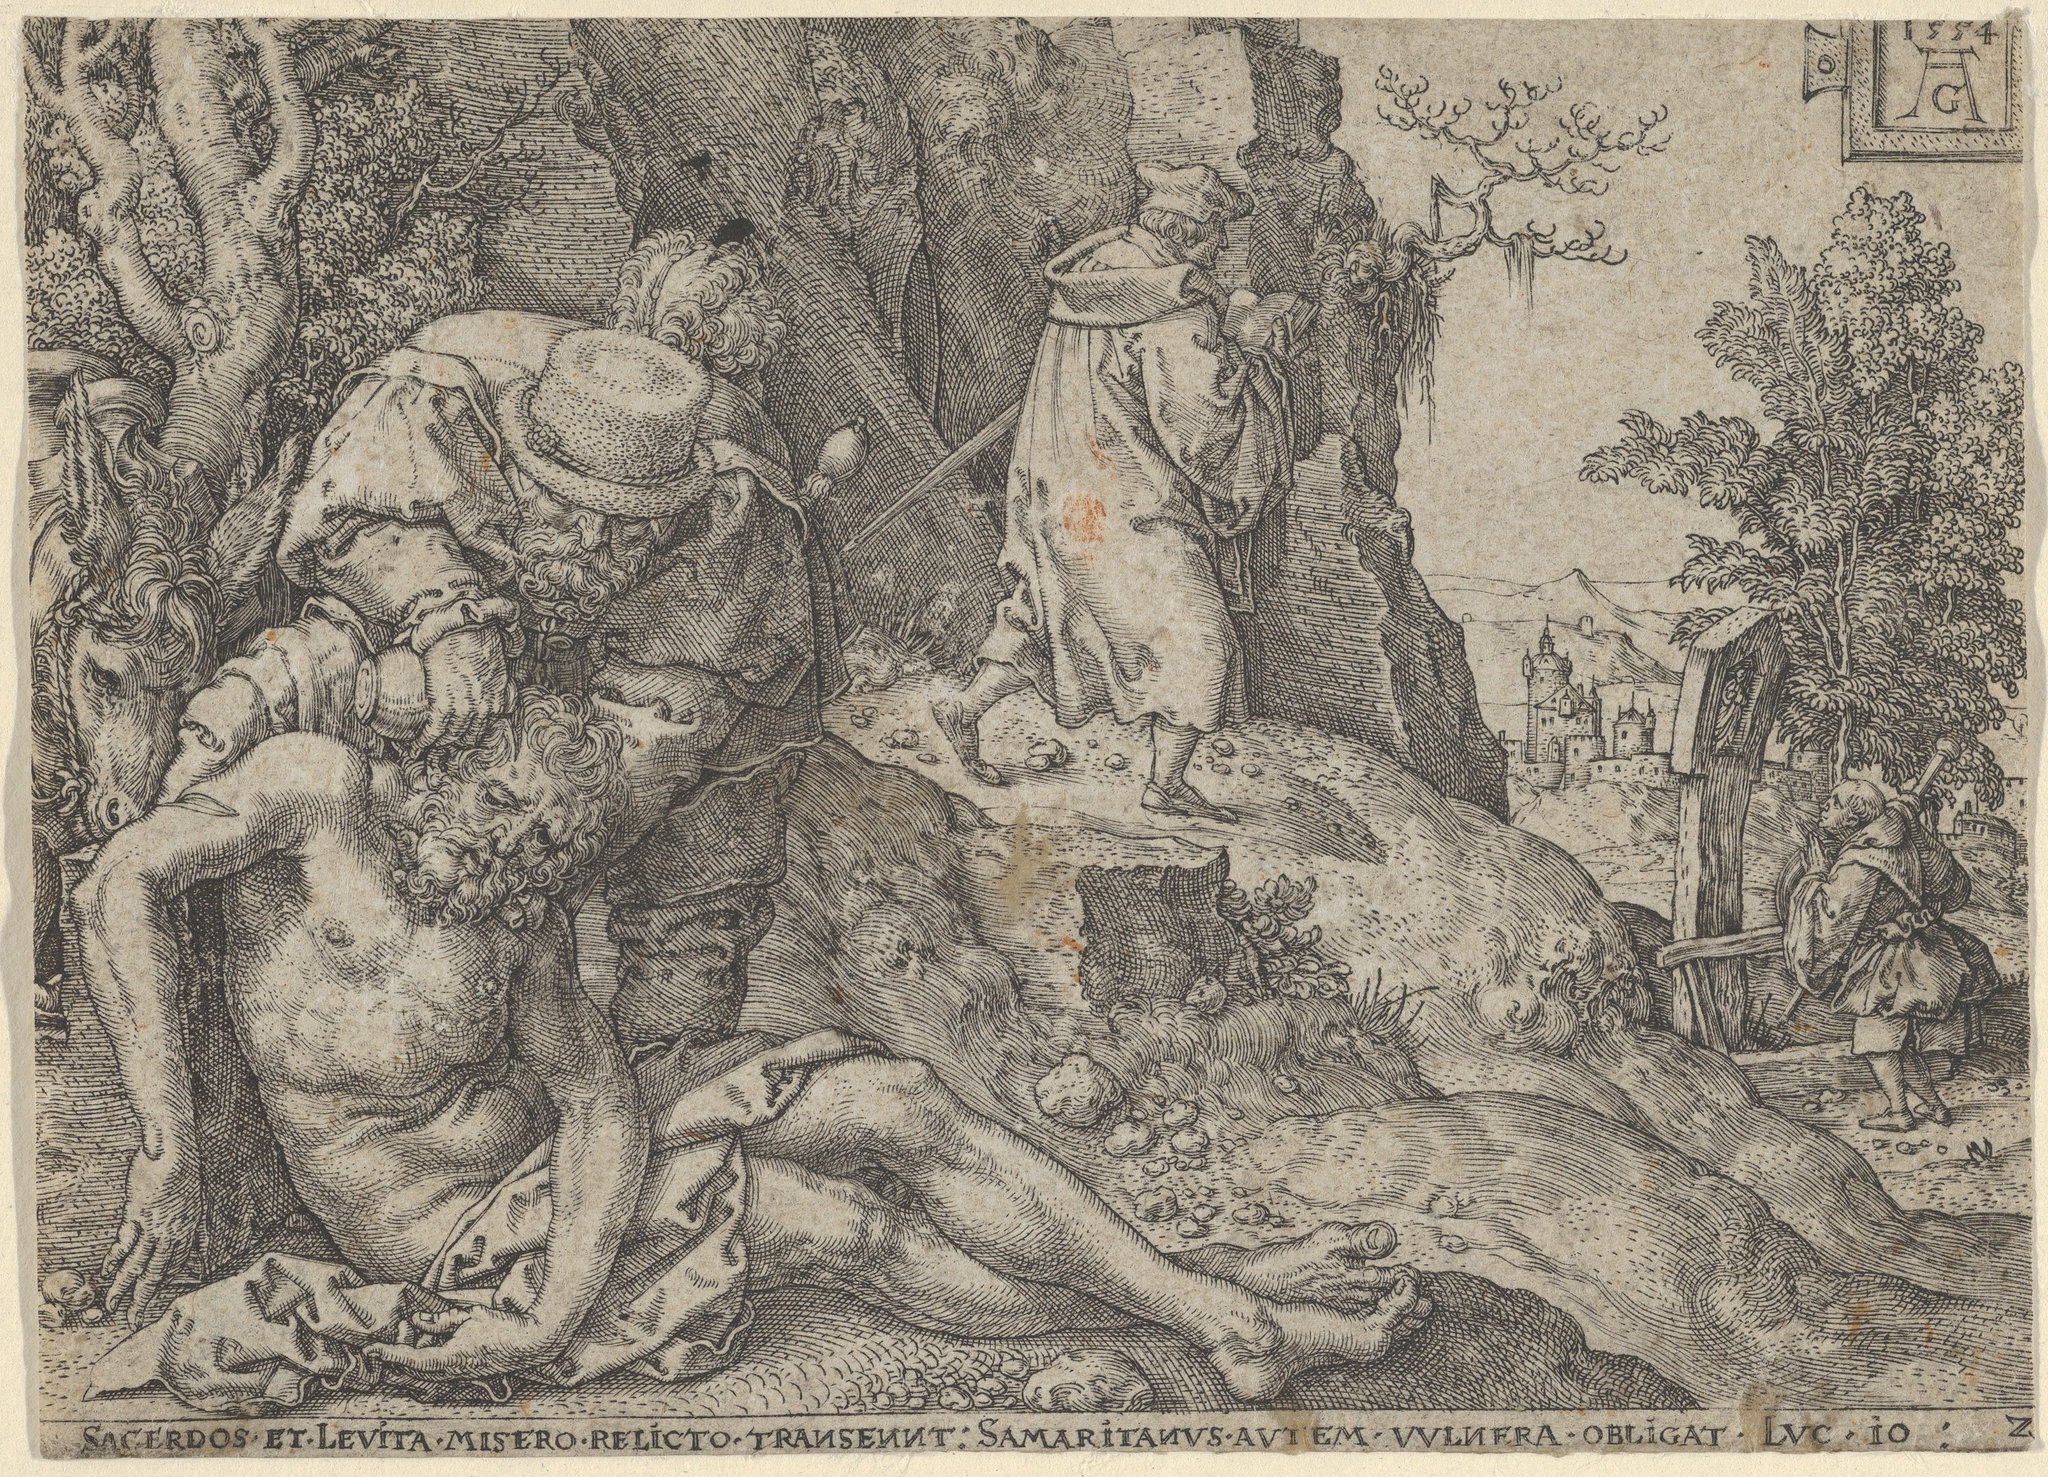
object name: print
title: The Good Samaritan Tending the Traveller's Wounds with Oil and Wine or The Priest and the Levite Passing, from "The Parable of the Good Samaritan"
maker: heinrich aldegrever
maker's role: artist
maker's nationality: german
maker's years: 1502-1561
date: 1554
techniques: engraving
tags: illness,suffering,men